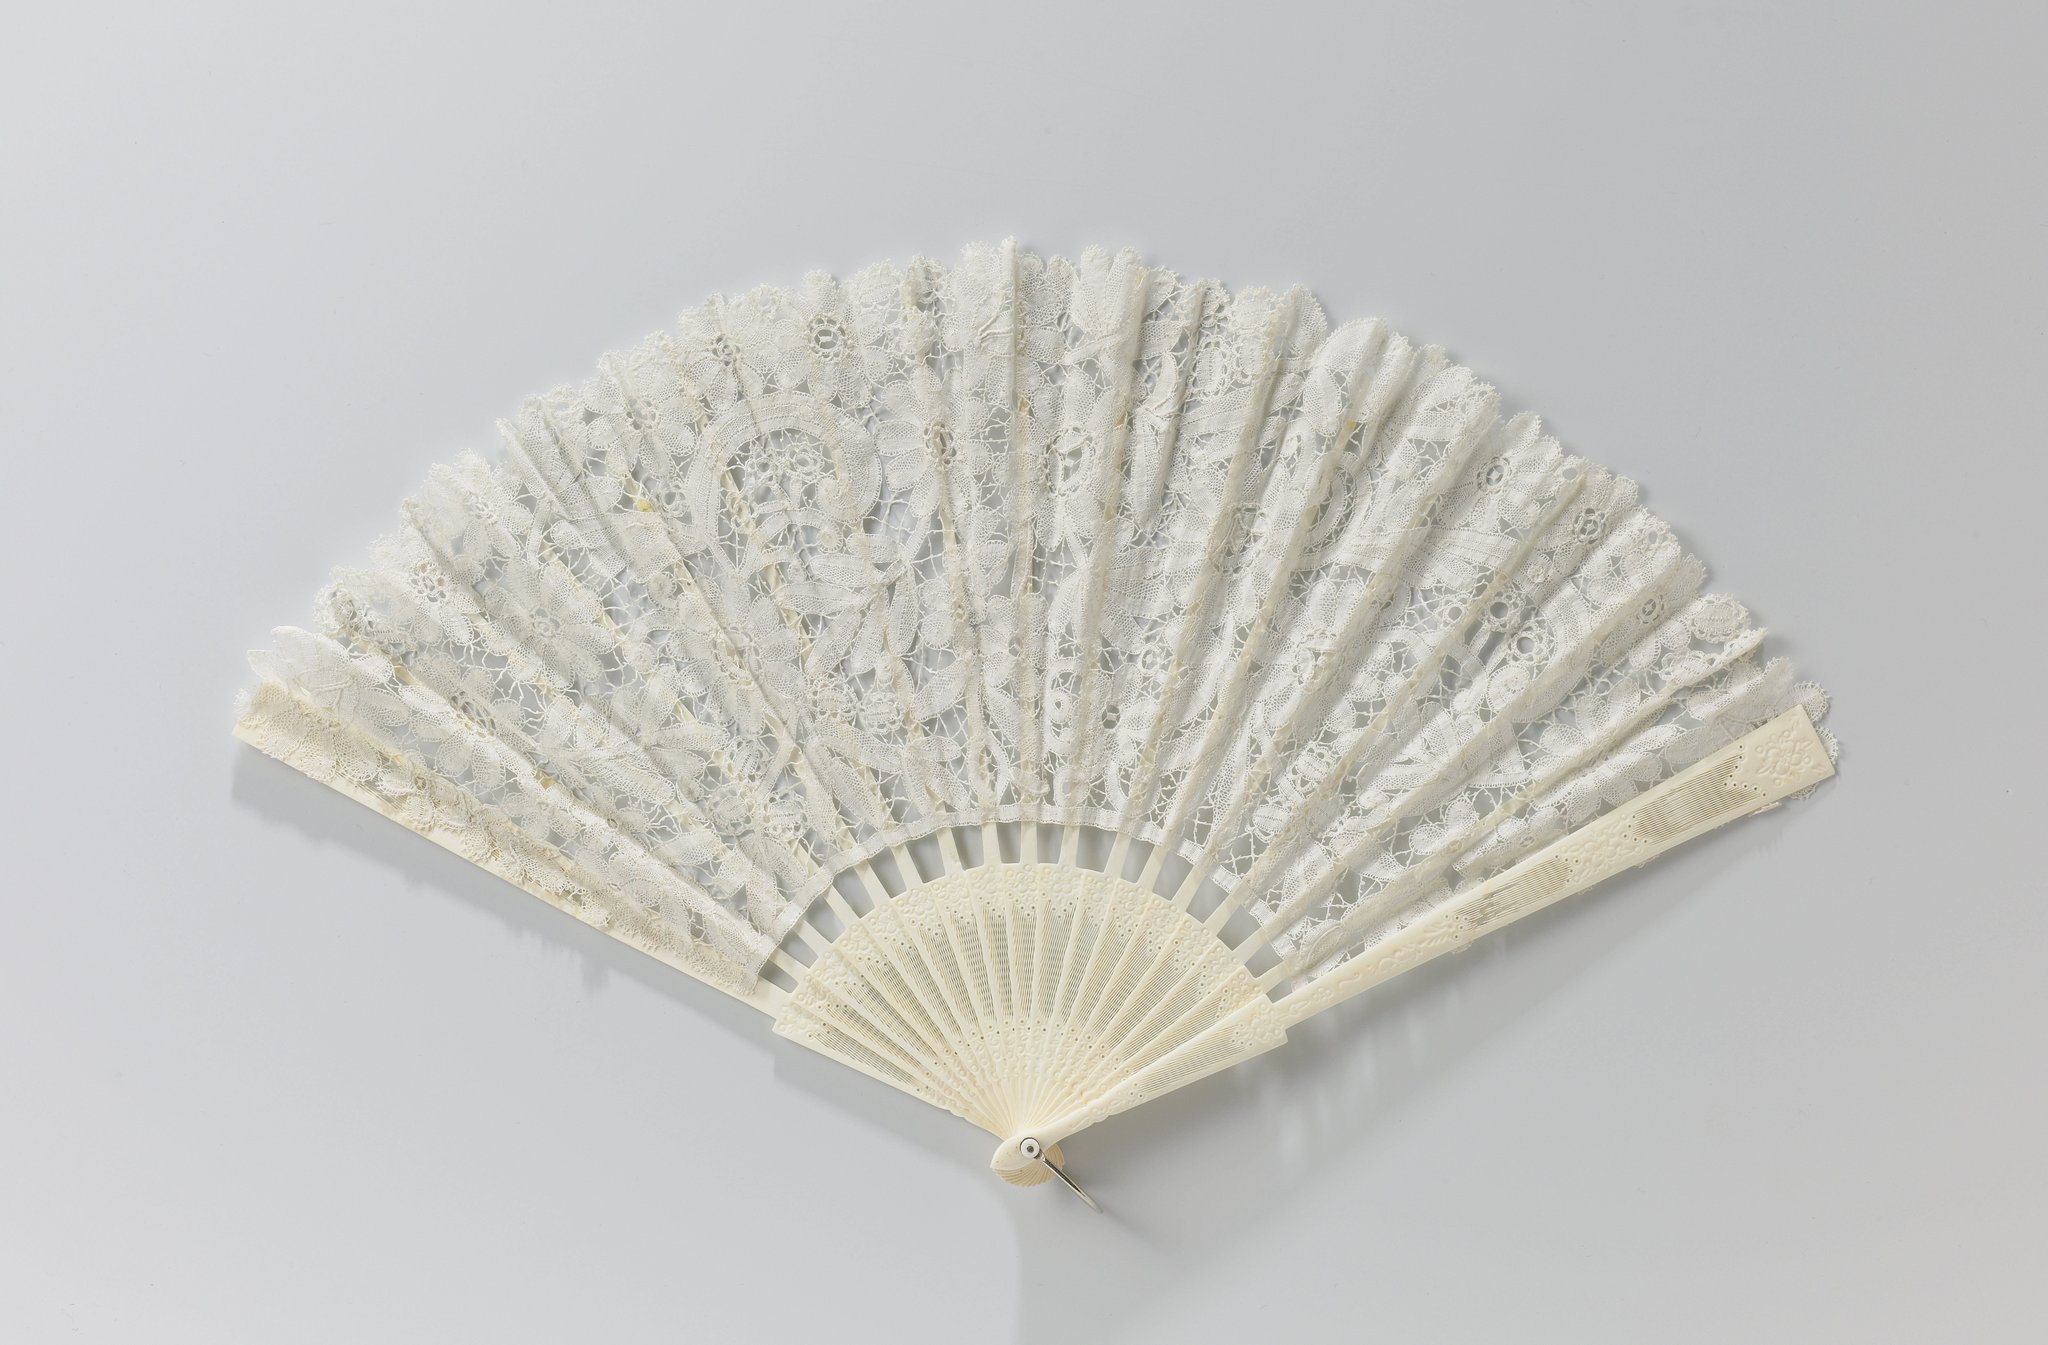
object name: vouwwaaier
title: Vouwwaaier met blad van Duchesse kant, met margrieten en geschulpte rand, op een ajourmontuur van ivoor, voorzien van metalen waaierring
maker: Anonymous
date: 1914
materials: ivory, metal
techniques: cutting, lace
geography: netherlands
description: Vouwwaaier met blad van Duchesse kloskant op een montuur van ivoor, voorzien van metalen waaierring. Blad met margrieten en bladeren en geschulpte rand. De 17 benen zijn aaneengesloten en gedeeltelijk in een ruitmotief opengesneden, gedeeltelijk met bloemen in relief gesneden.